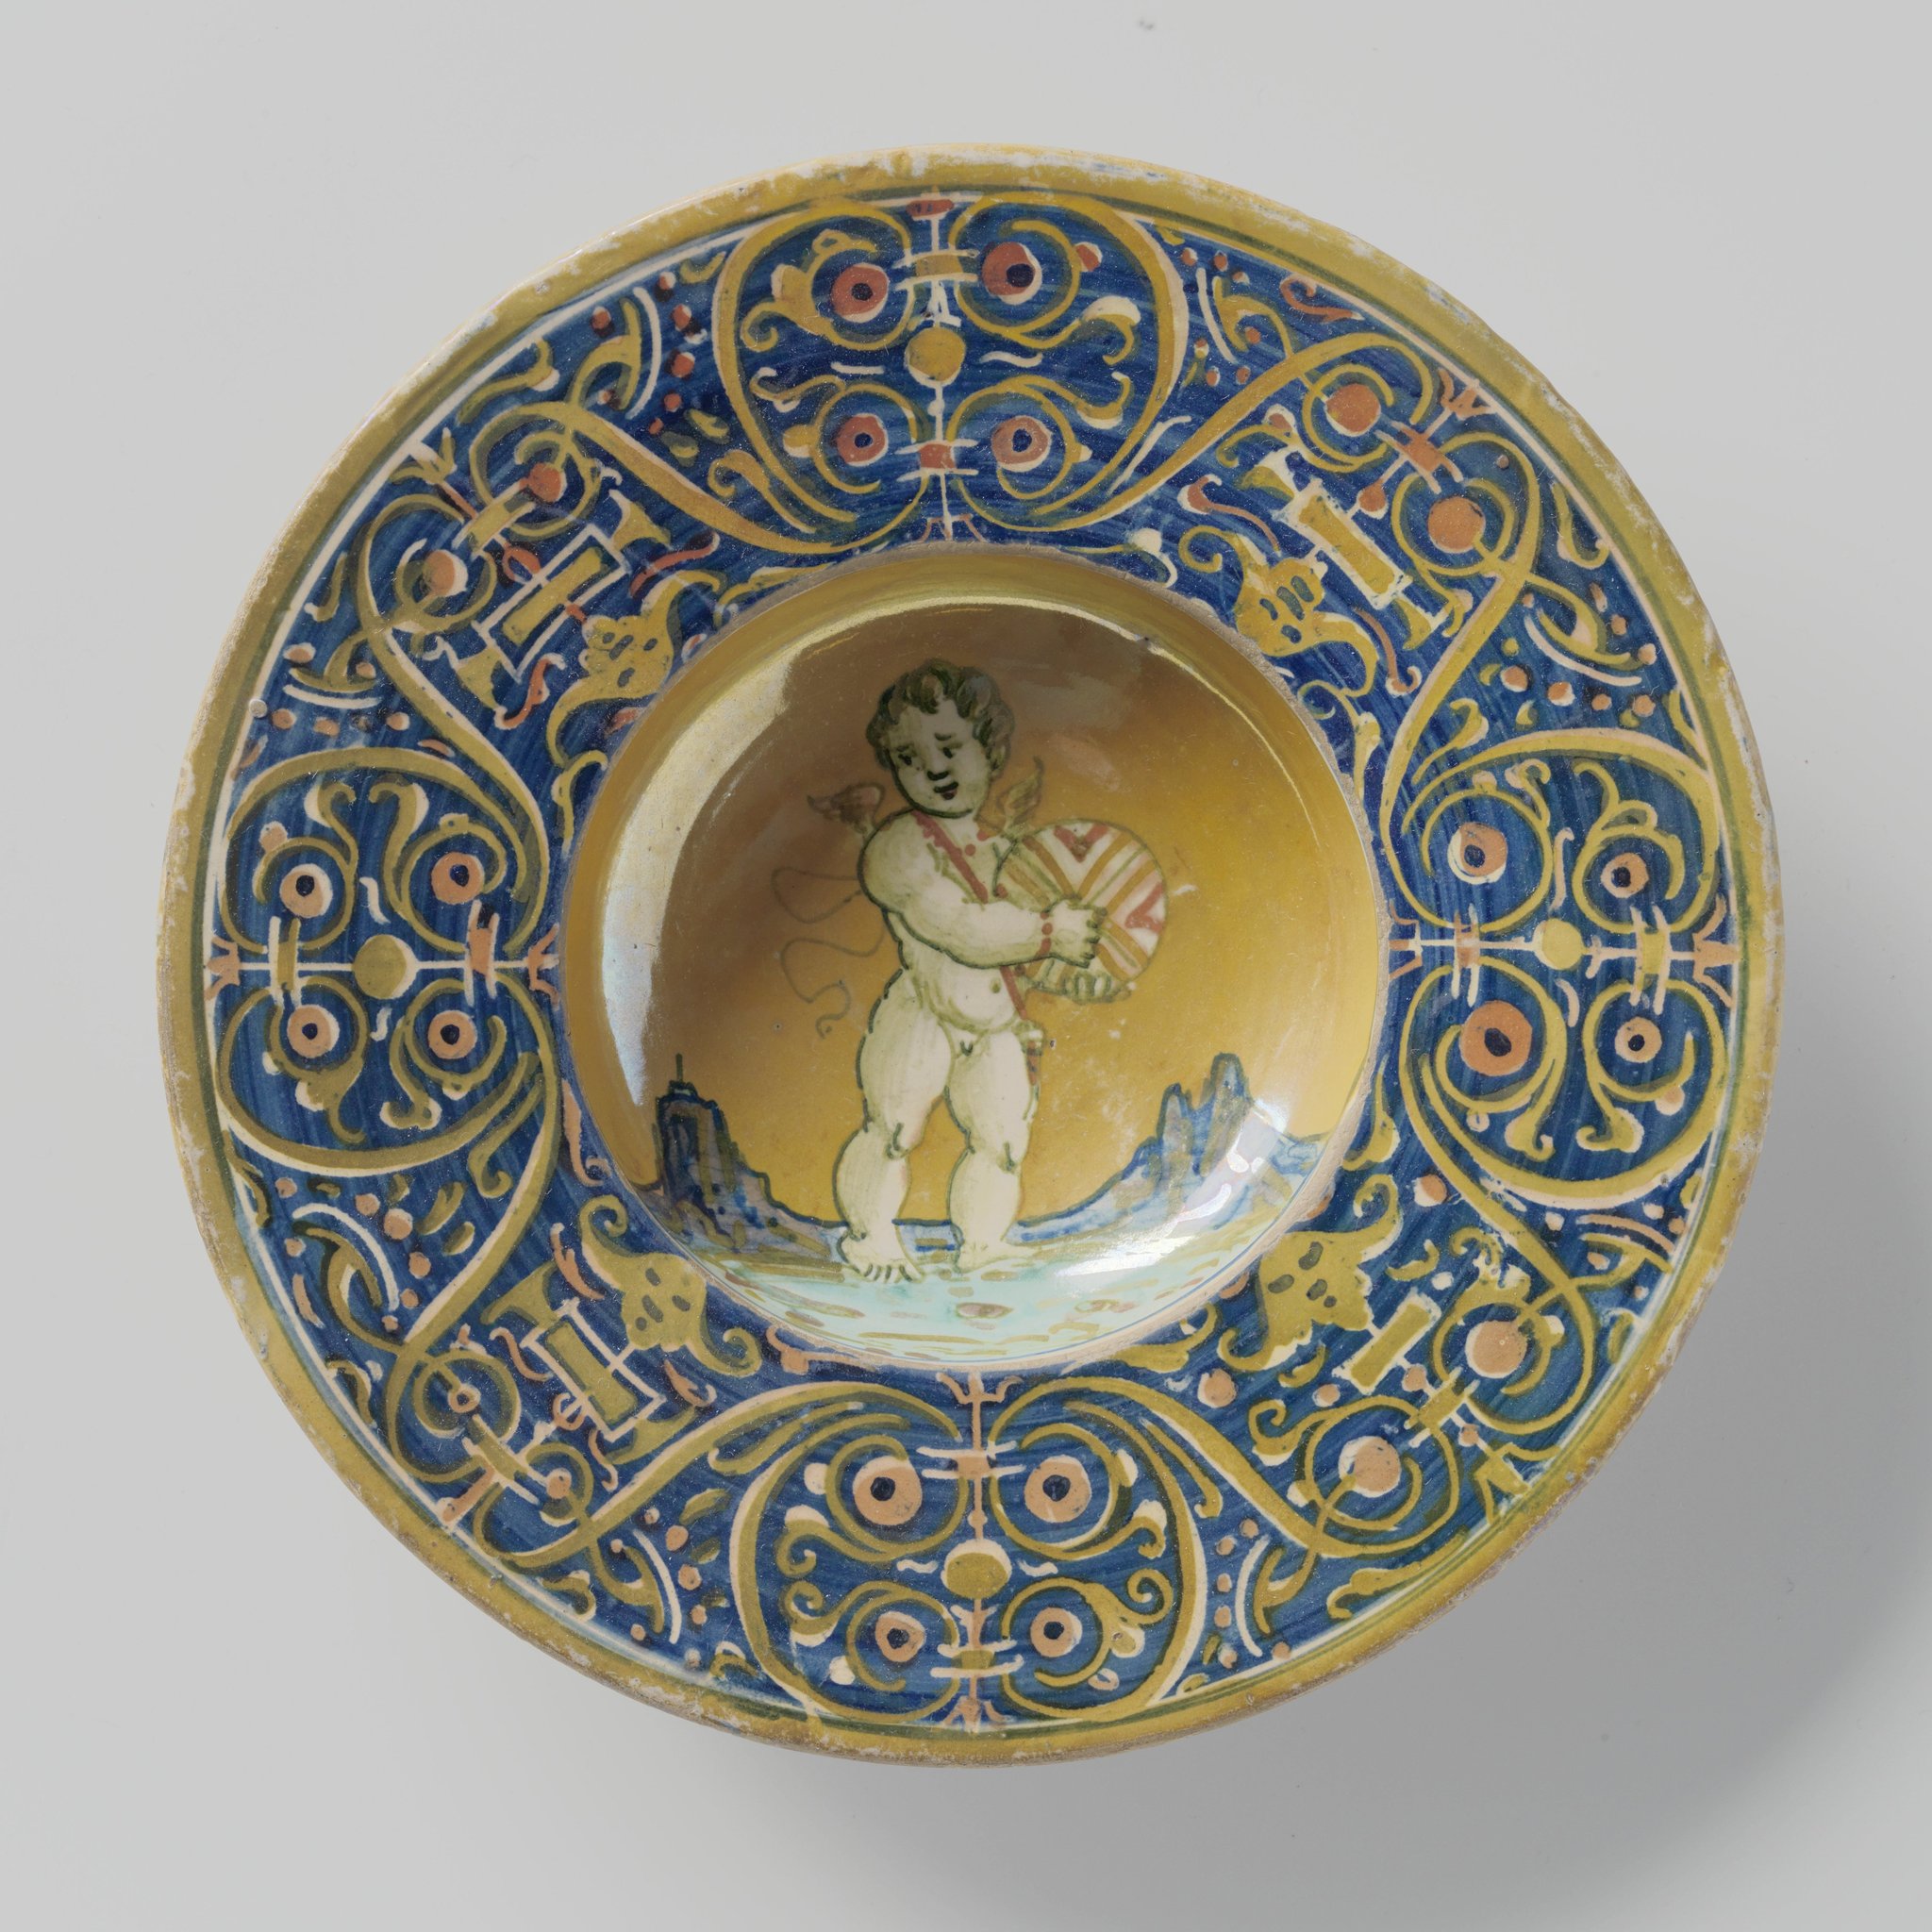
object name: plate dish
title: Bord met verdiept plat met veelkleurig beschilderde putto met bol in beide handen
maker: Anonymous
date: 1530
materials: earthenware, glaze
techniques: maiolica, painted, polychromy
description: Bord met voorstelling van een putto. Majolica met een extra decoratie in metaalluster. Gubbio, ca. 1525 - 1535.